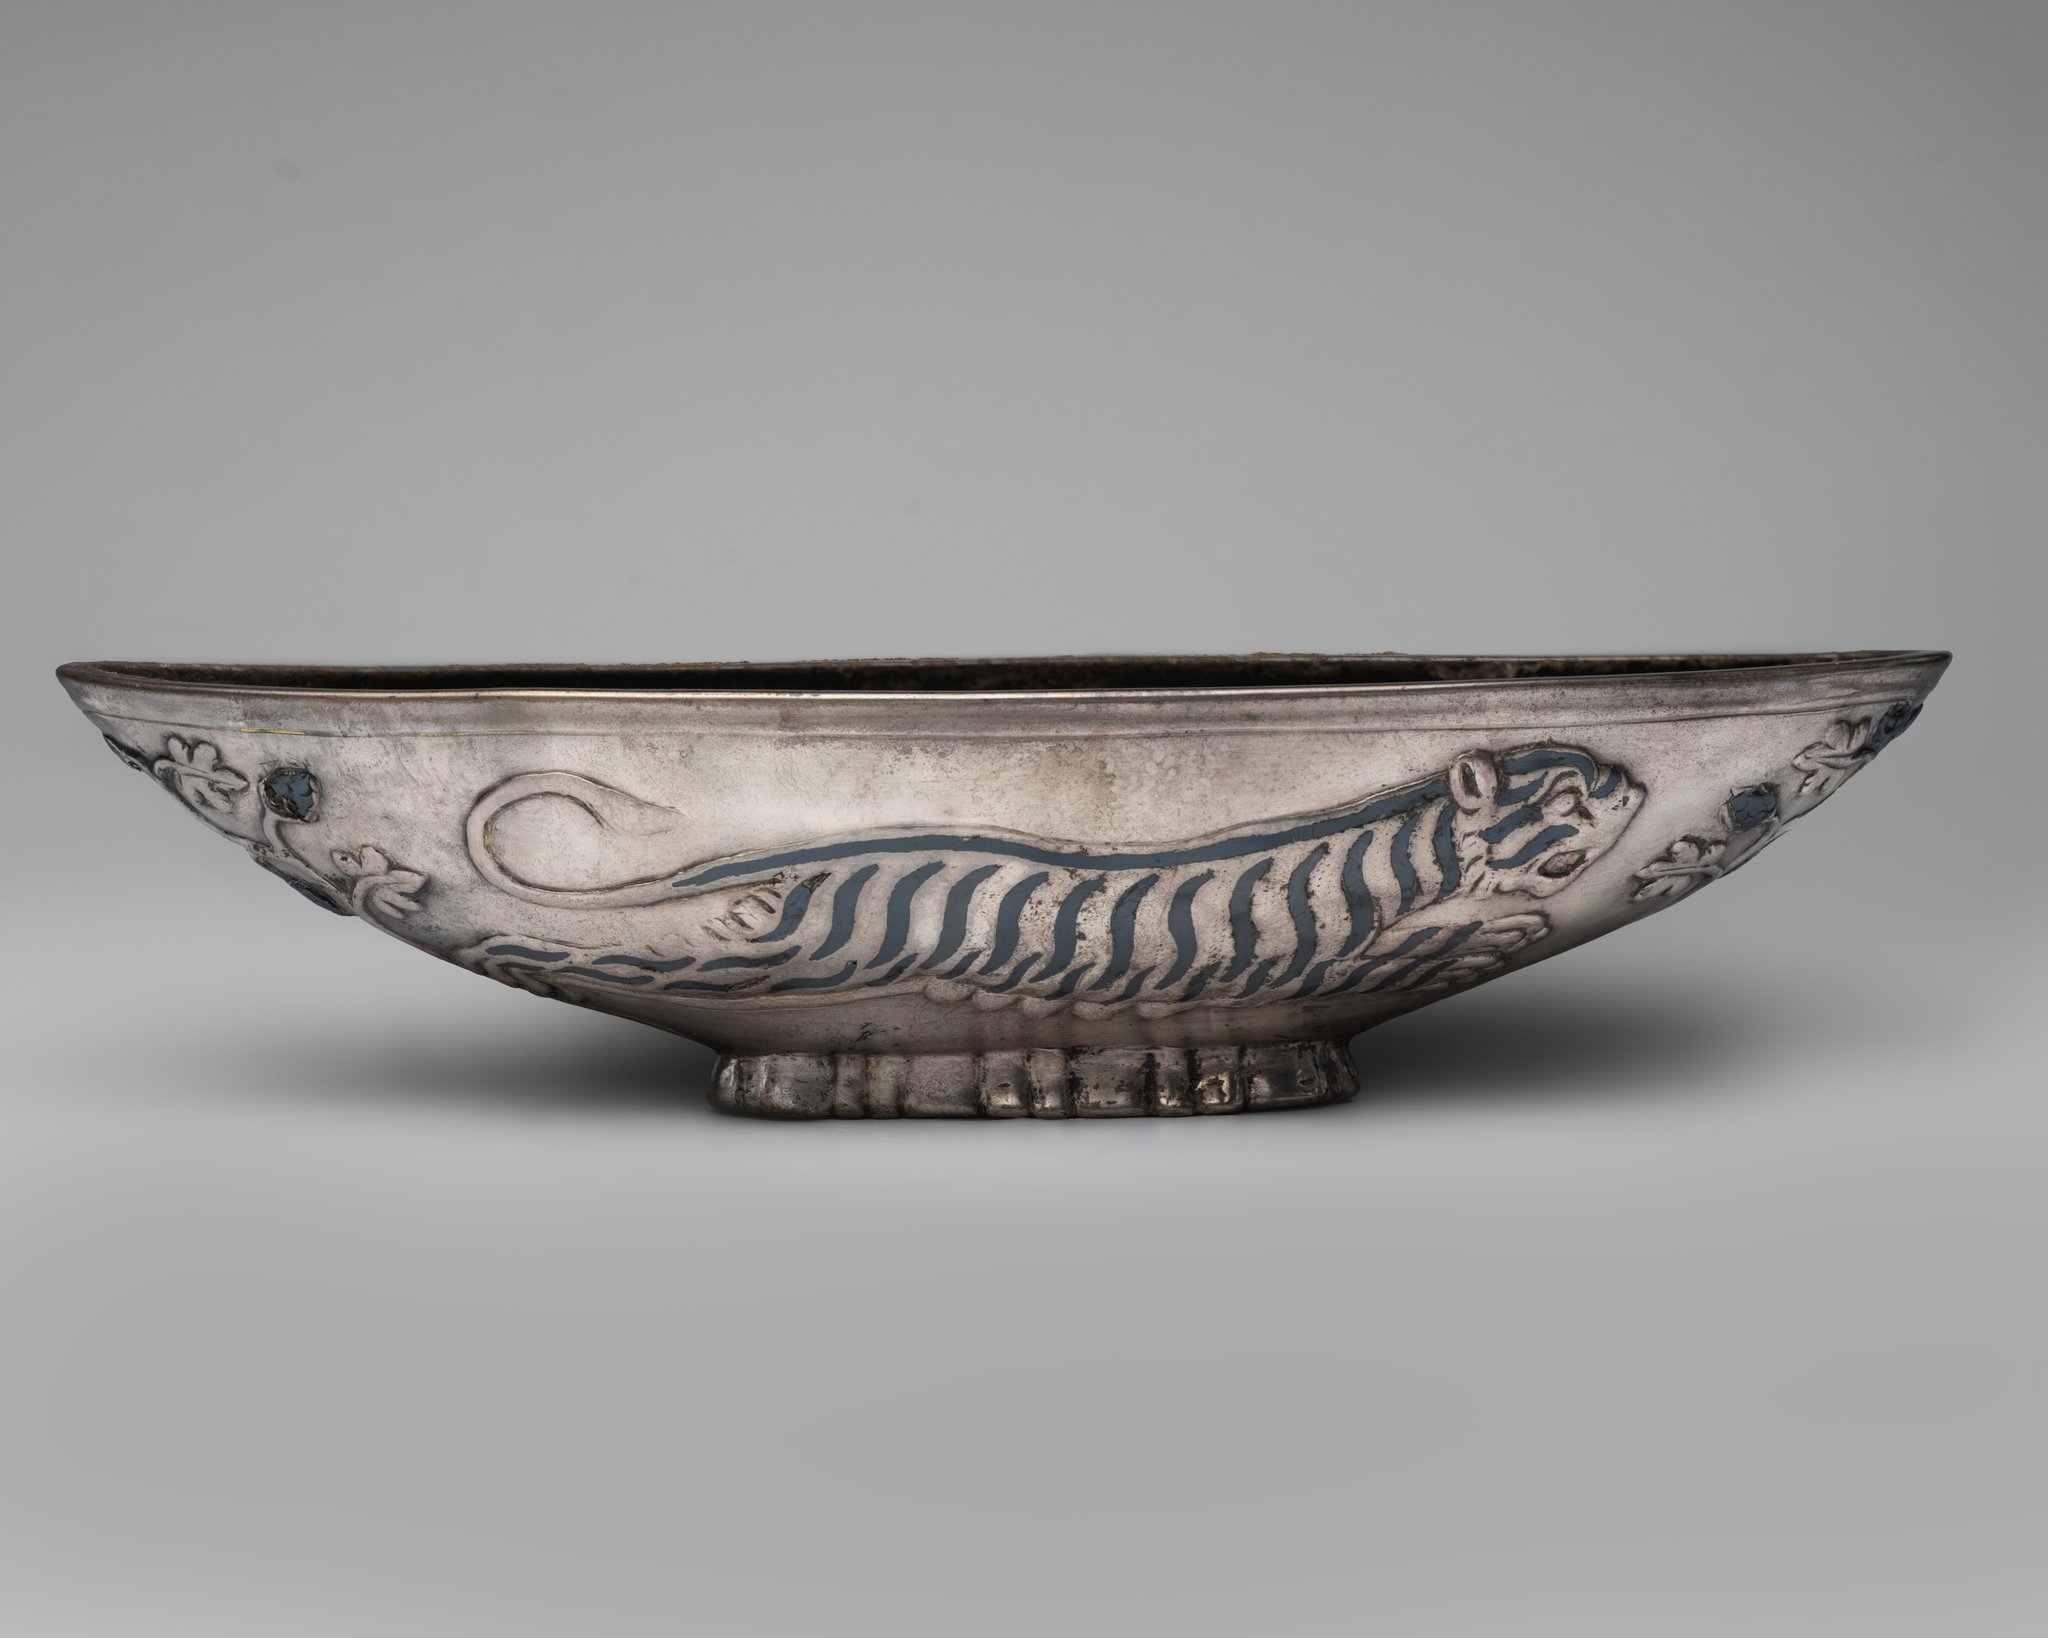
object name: bowl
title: Oval bowl with running tigresses on each side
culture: sasanian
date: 501-700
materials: niello, silver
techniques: inlay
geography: iran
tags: tigers